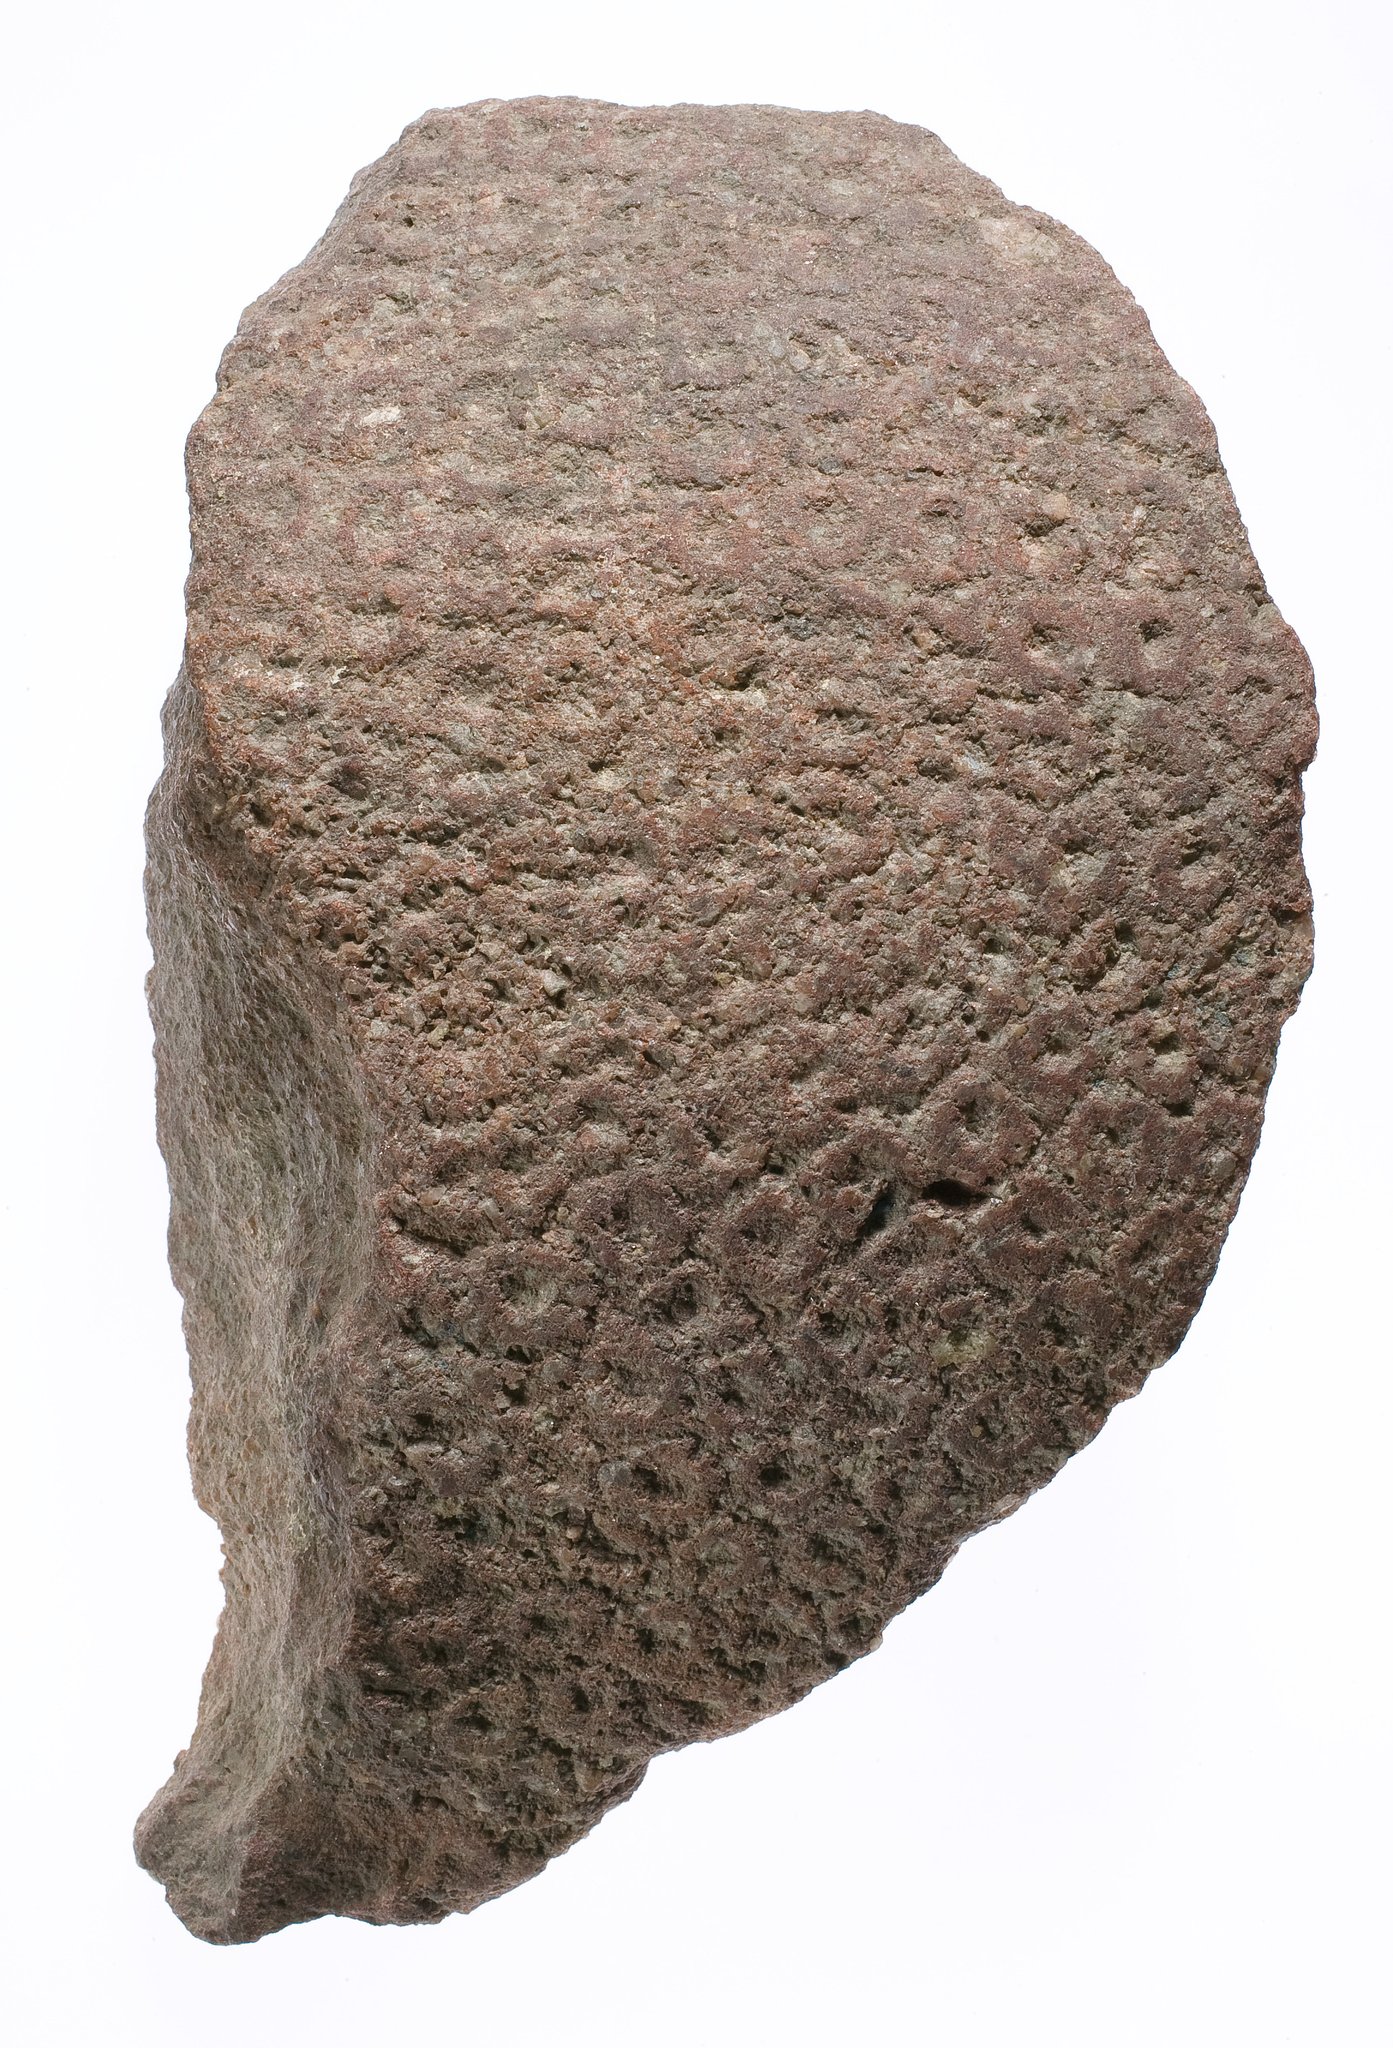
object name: crown with disc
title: Crown with discs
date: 1353-1336 BCE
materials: quartzite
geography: egypt